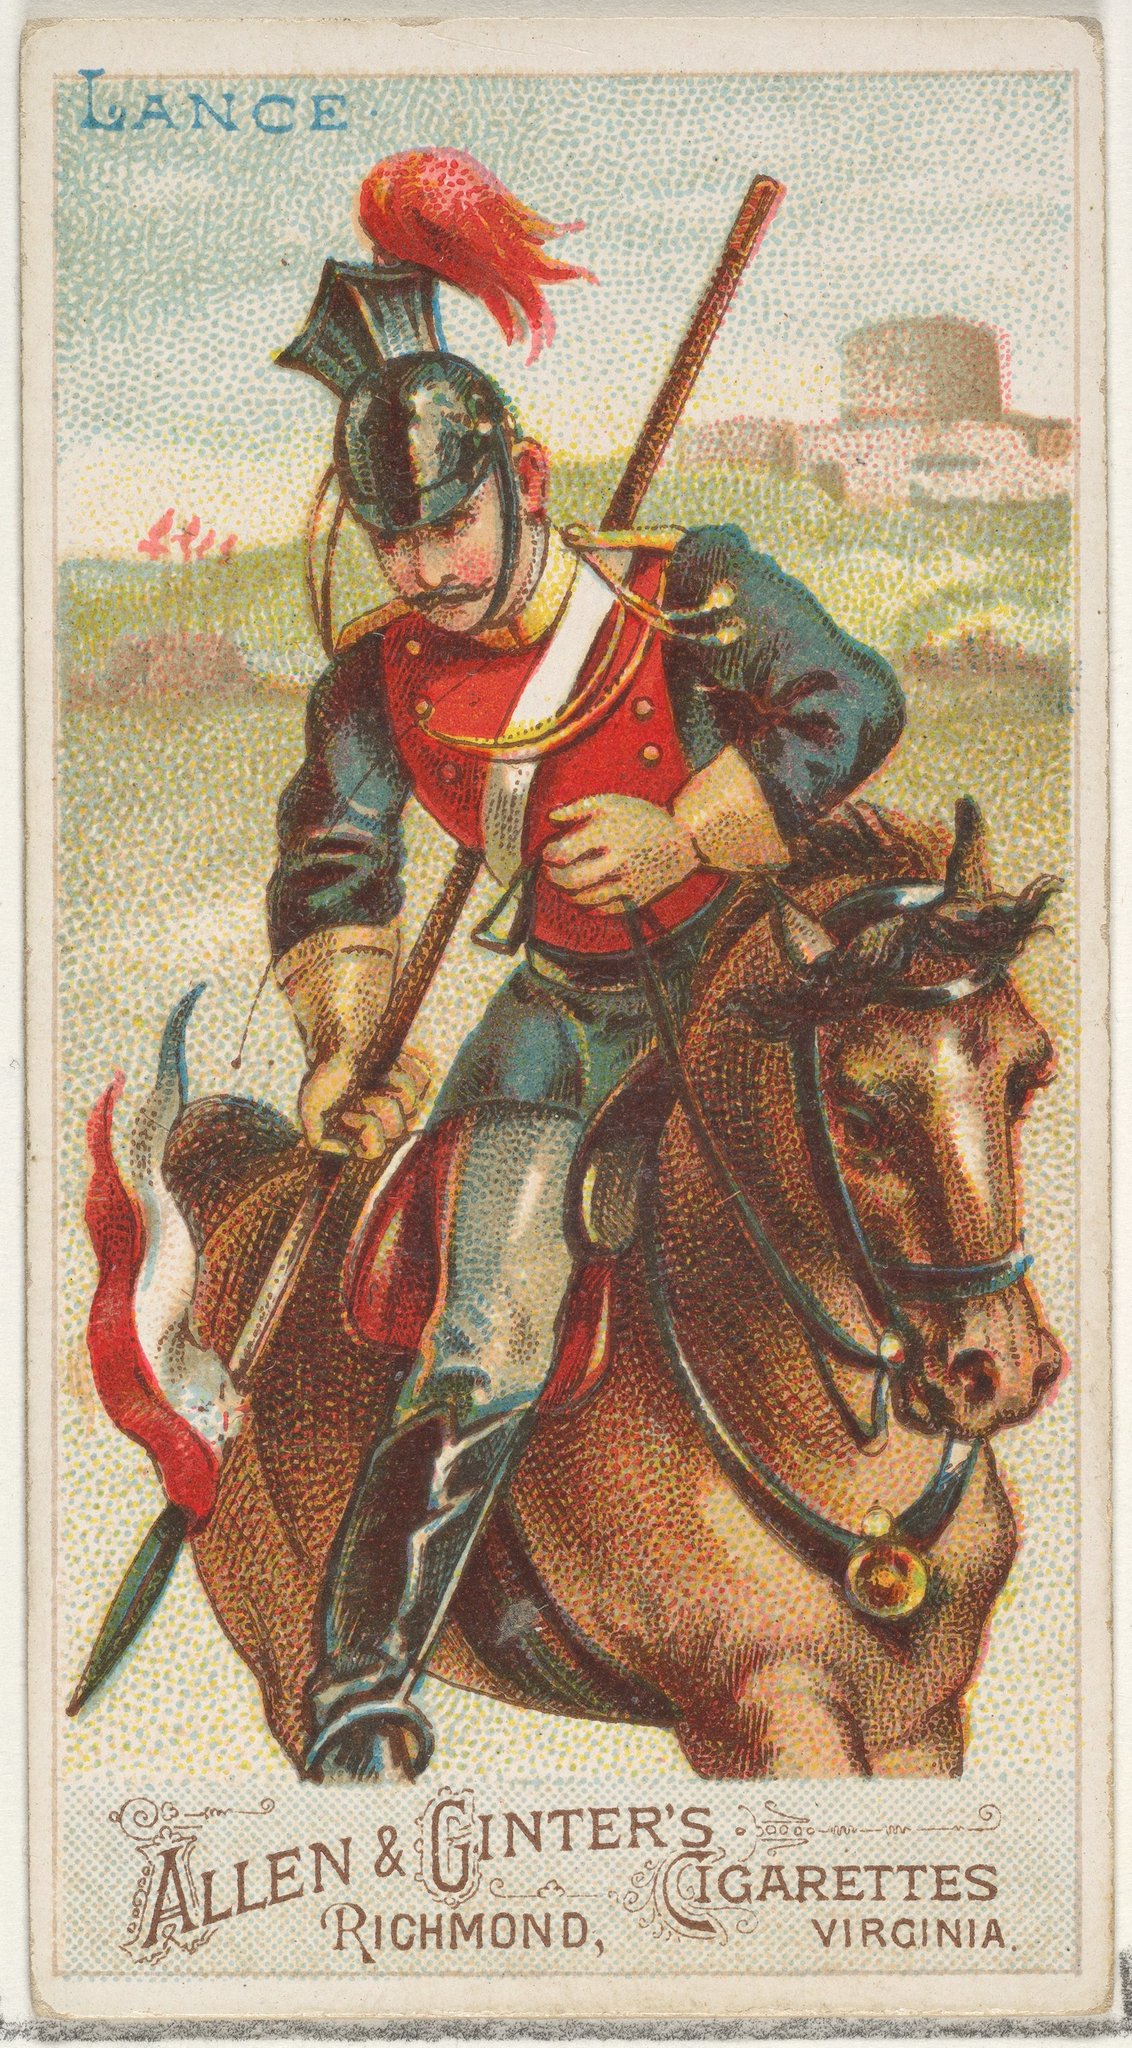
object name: print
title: Lance, from the Arms of All Nations series (N3) for Allen & Ginter Cigarettes Brands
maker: allen & ginter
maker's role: publisher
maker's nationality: american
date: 1887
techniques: color lithograph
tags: weapons,men,horses